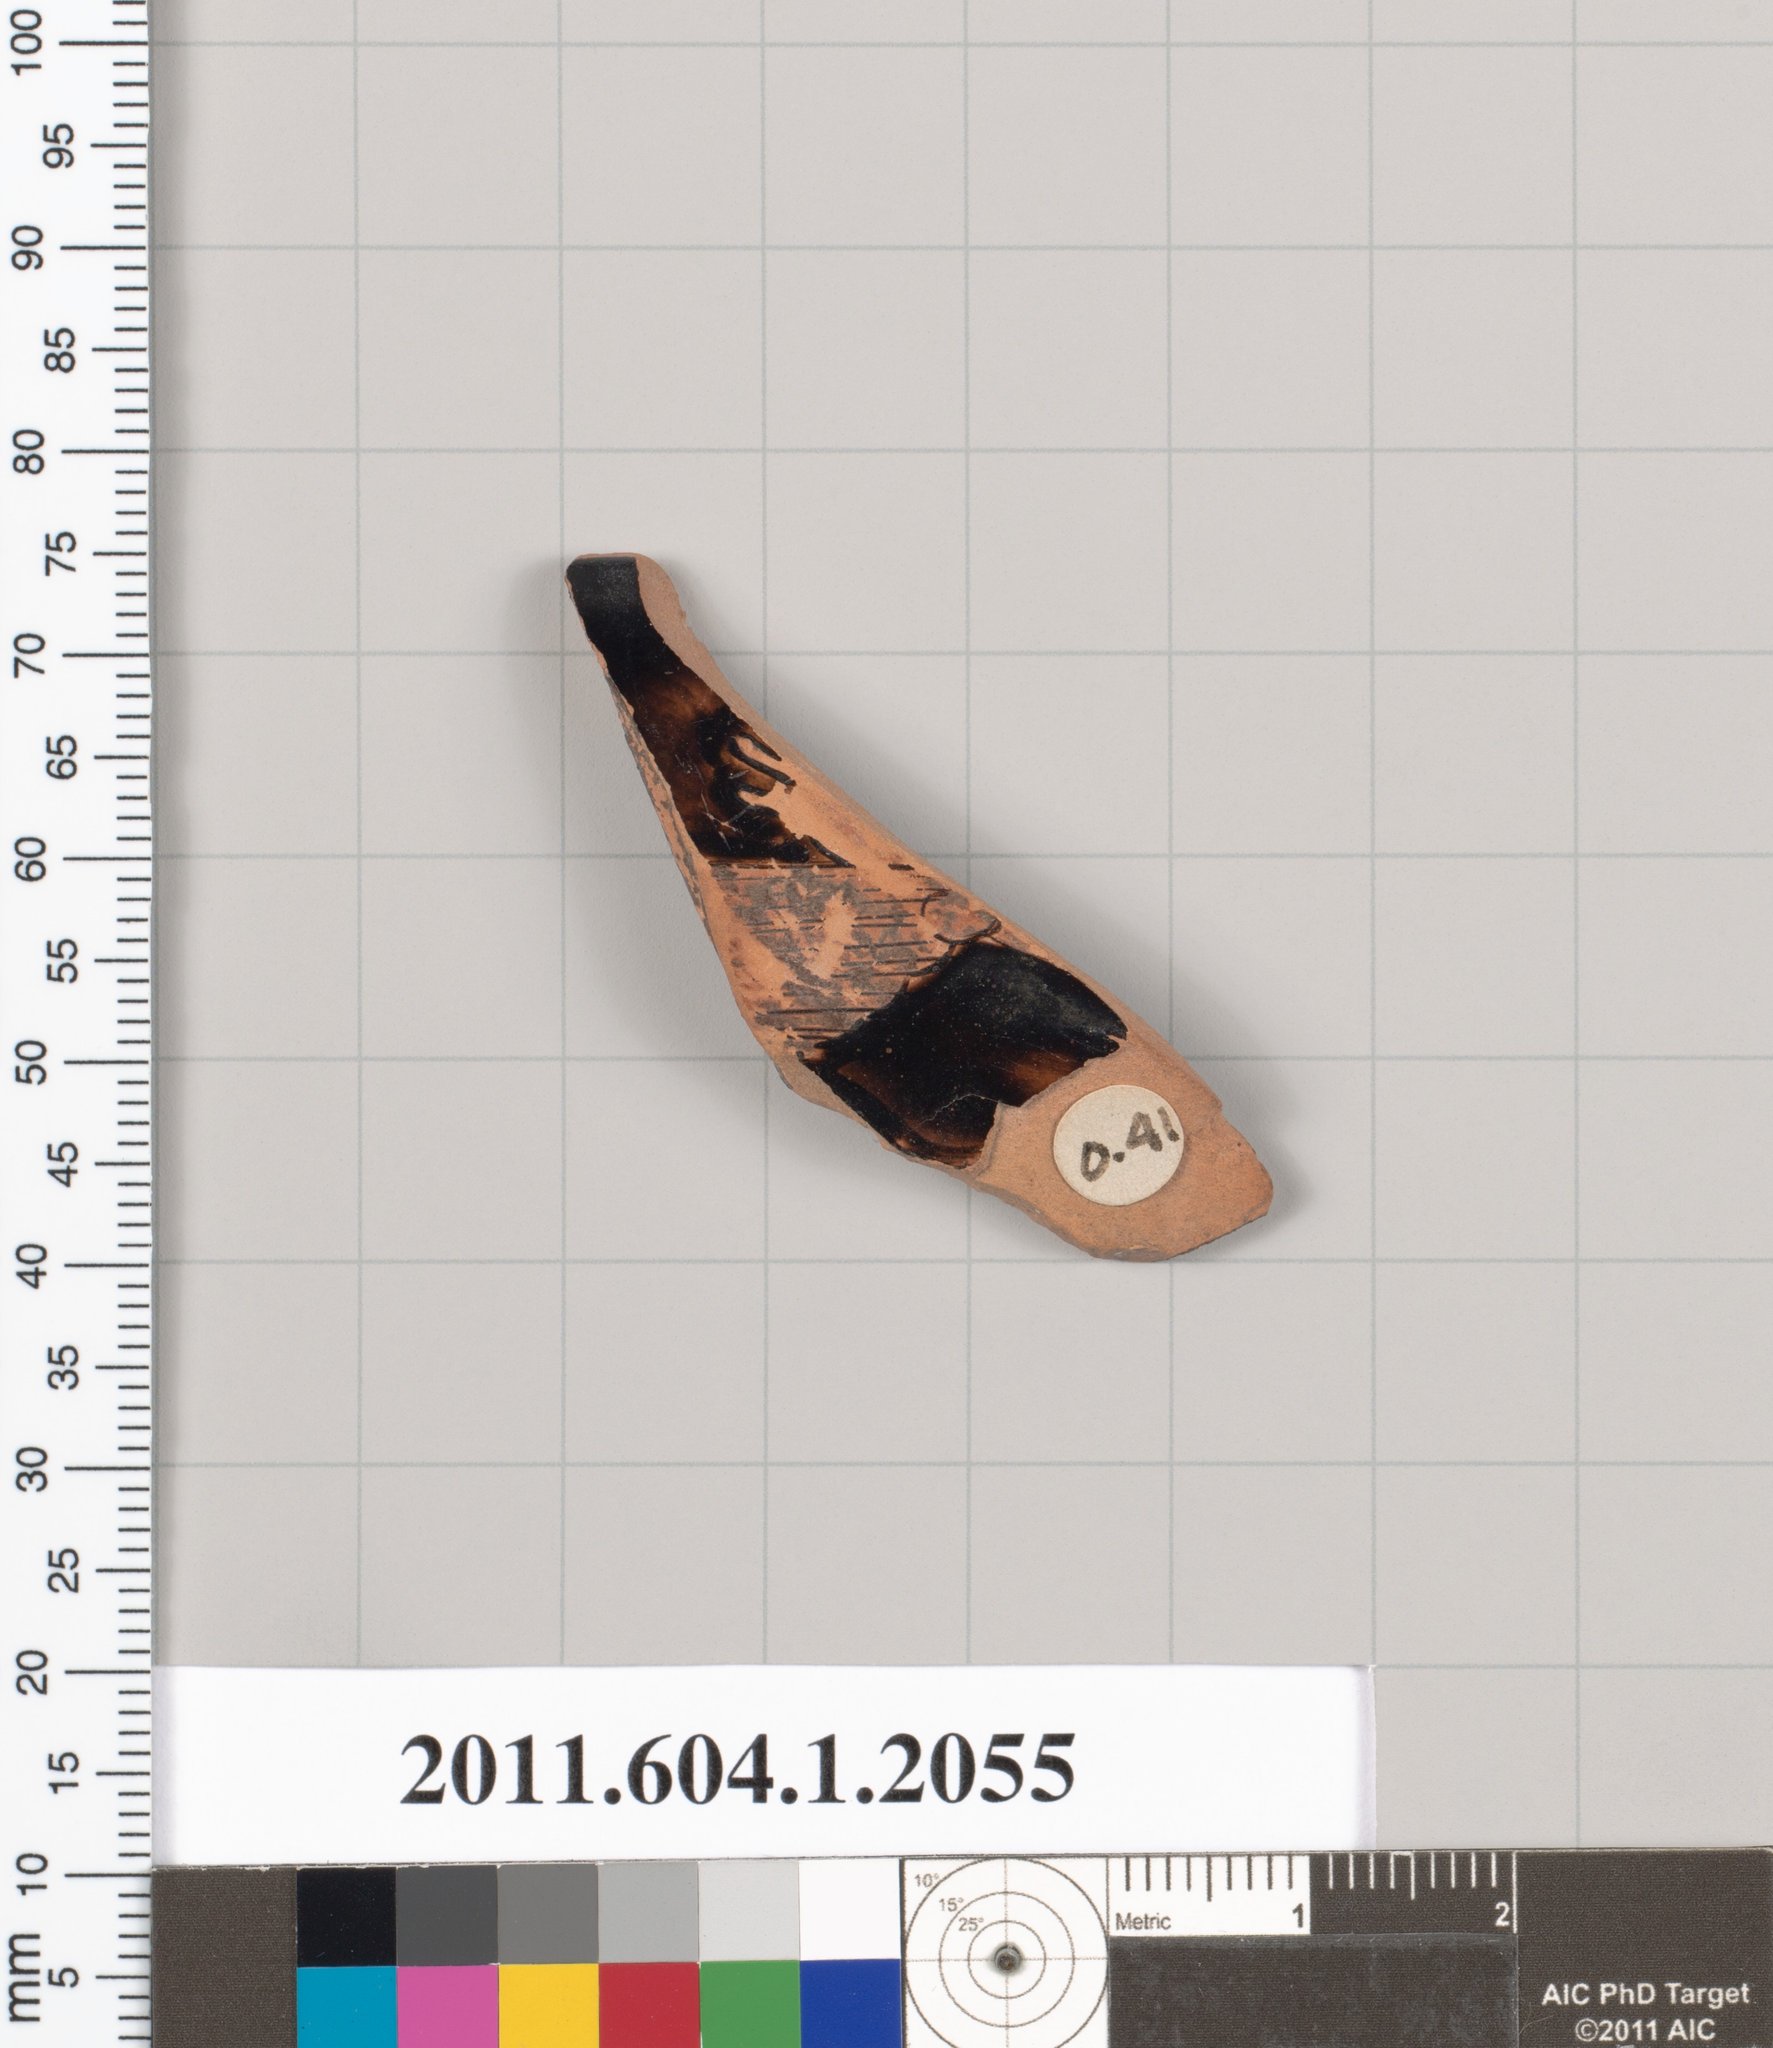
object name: kylix fragment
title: Terracotta rim fragment of a kylix (drinking cup)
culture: greek, attic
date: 475-451 BCE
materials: terracotta